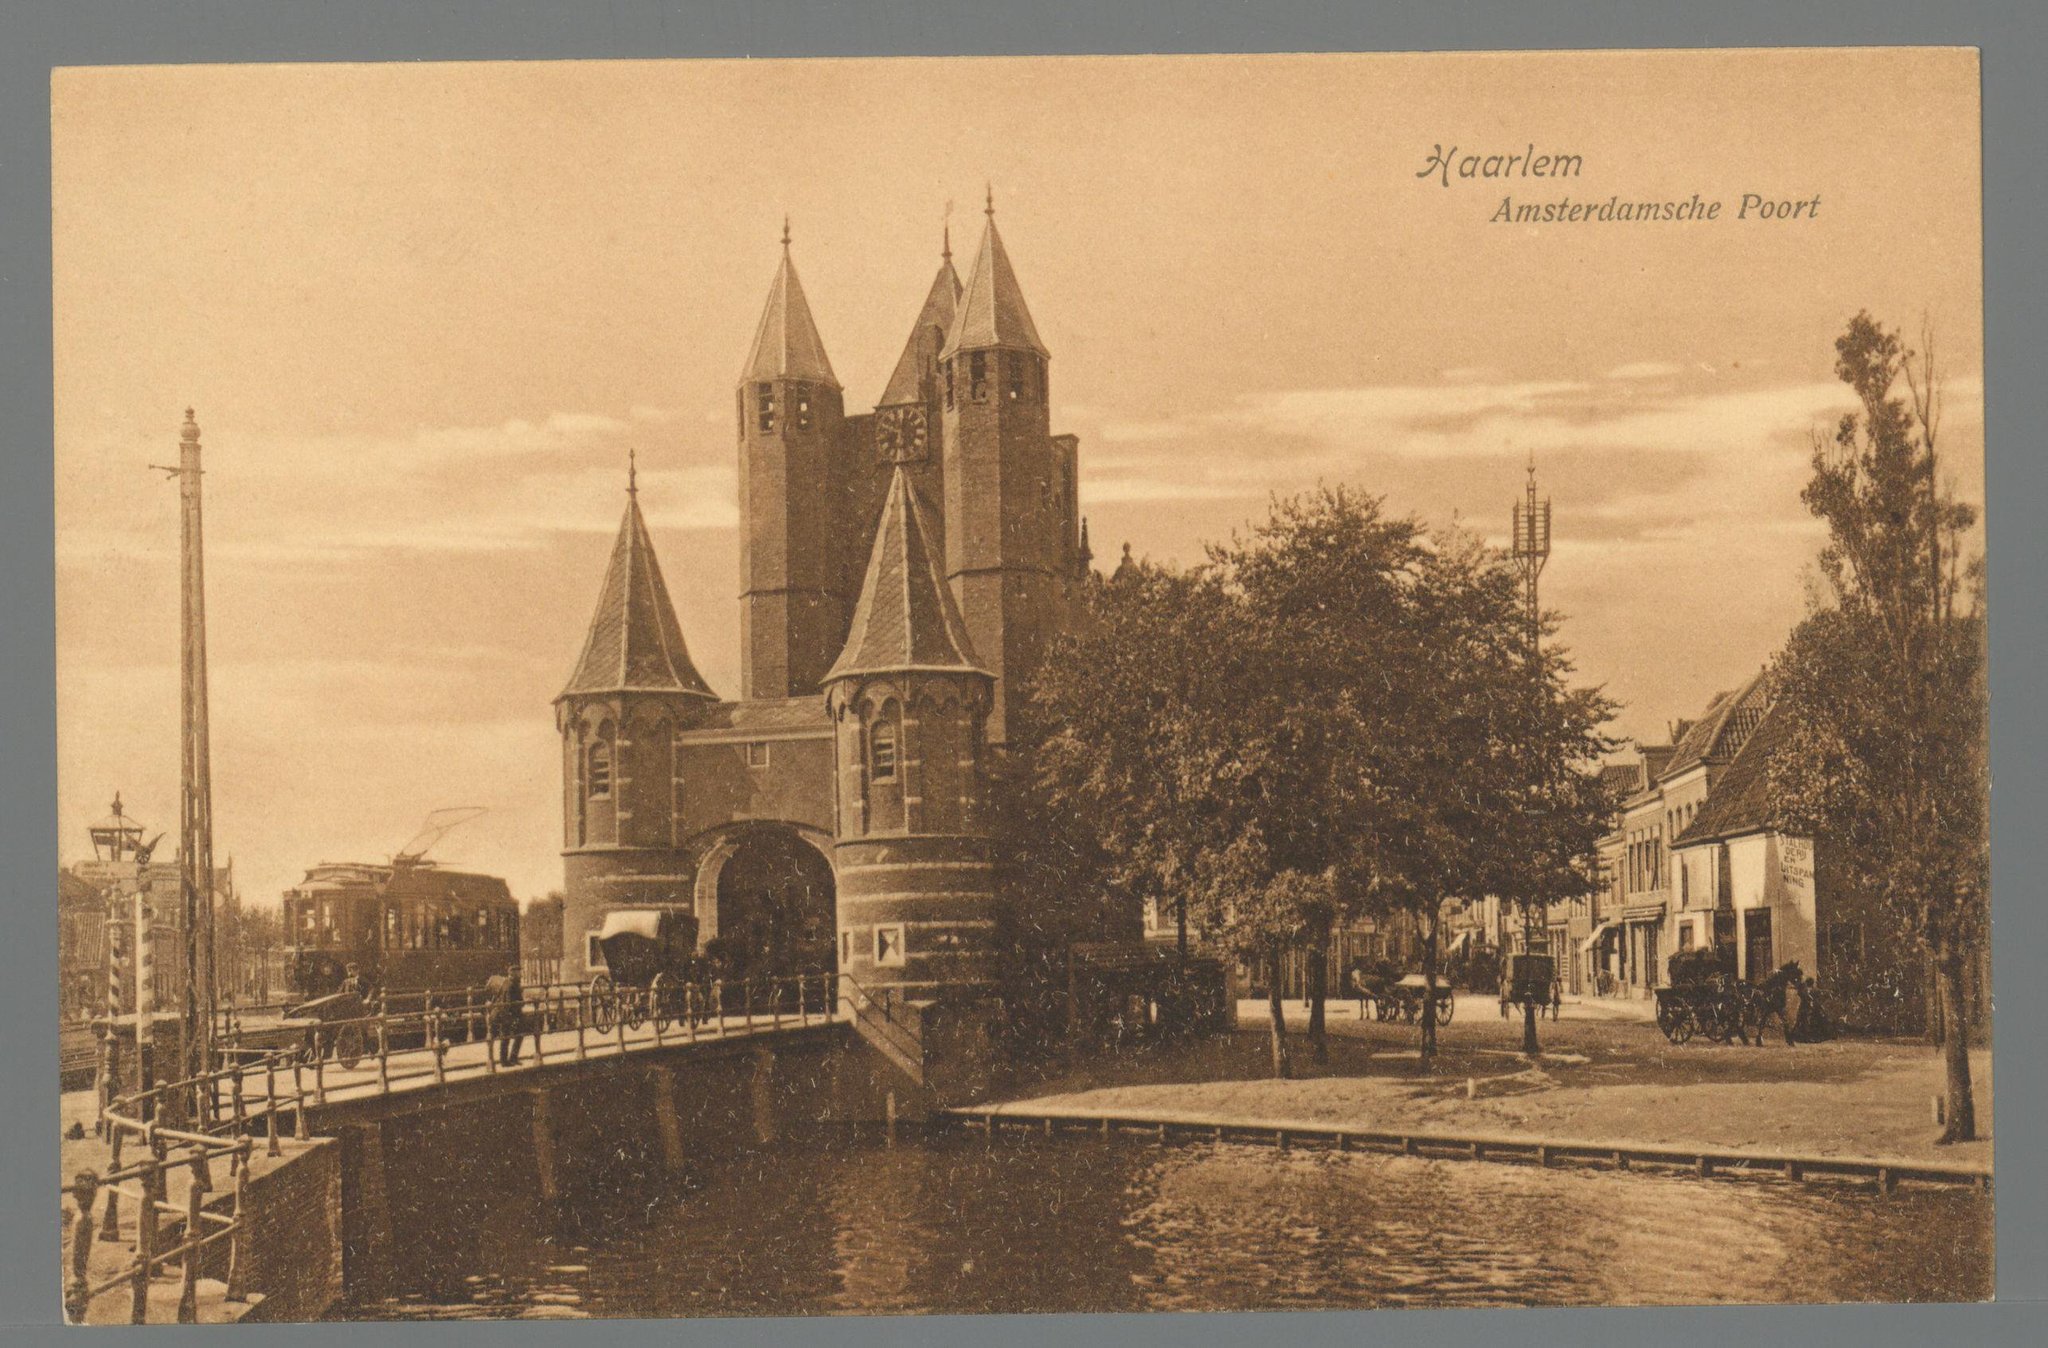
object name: ansichtkaart, prentbriefkaart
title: Haarlem. Amsterdamsche Poort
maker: Anonymous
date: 1911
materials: cardboard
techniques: photograph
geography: leipzig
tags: city-view, and landscape with man-made constructions, canals, waters (in city), bridge in city across river, canal, etc., city-gate, haarlem